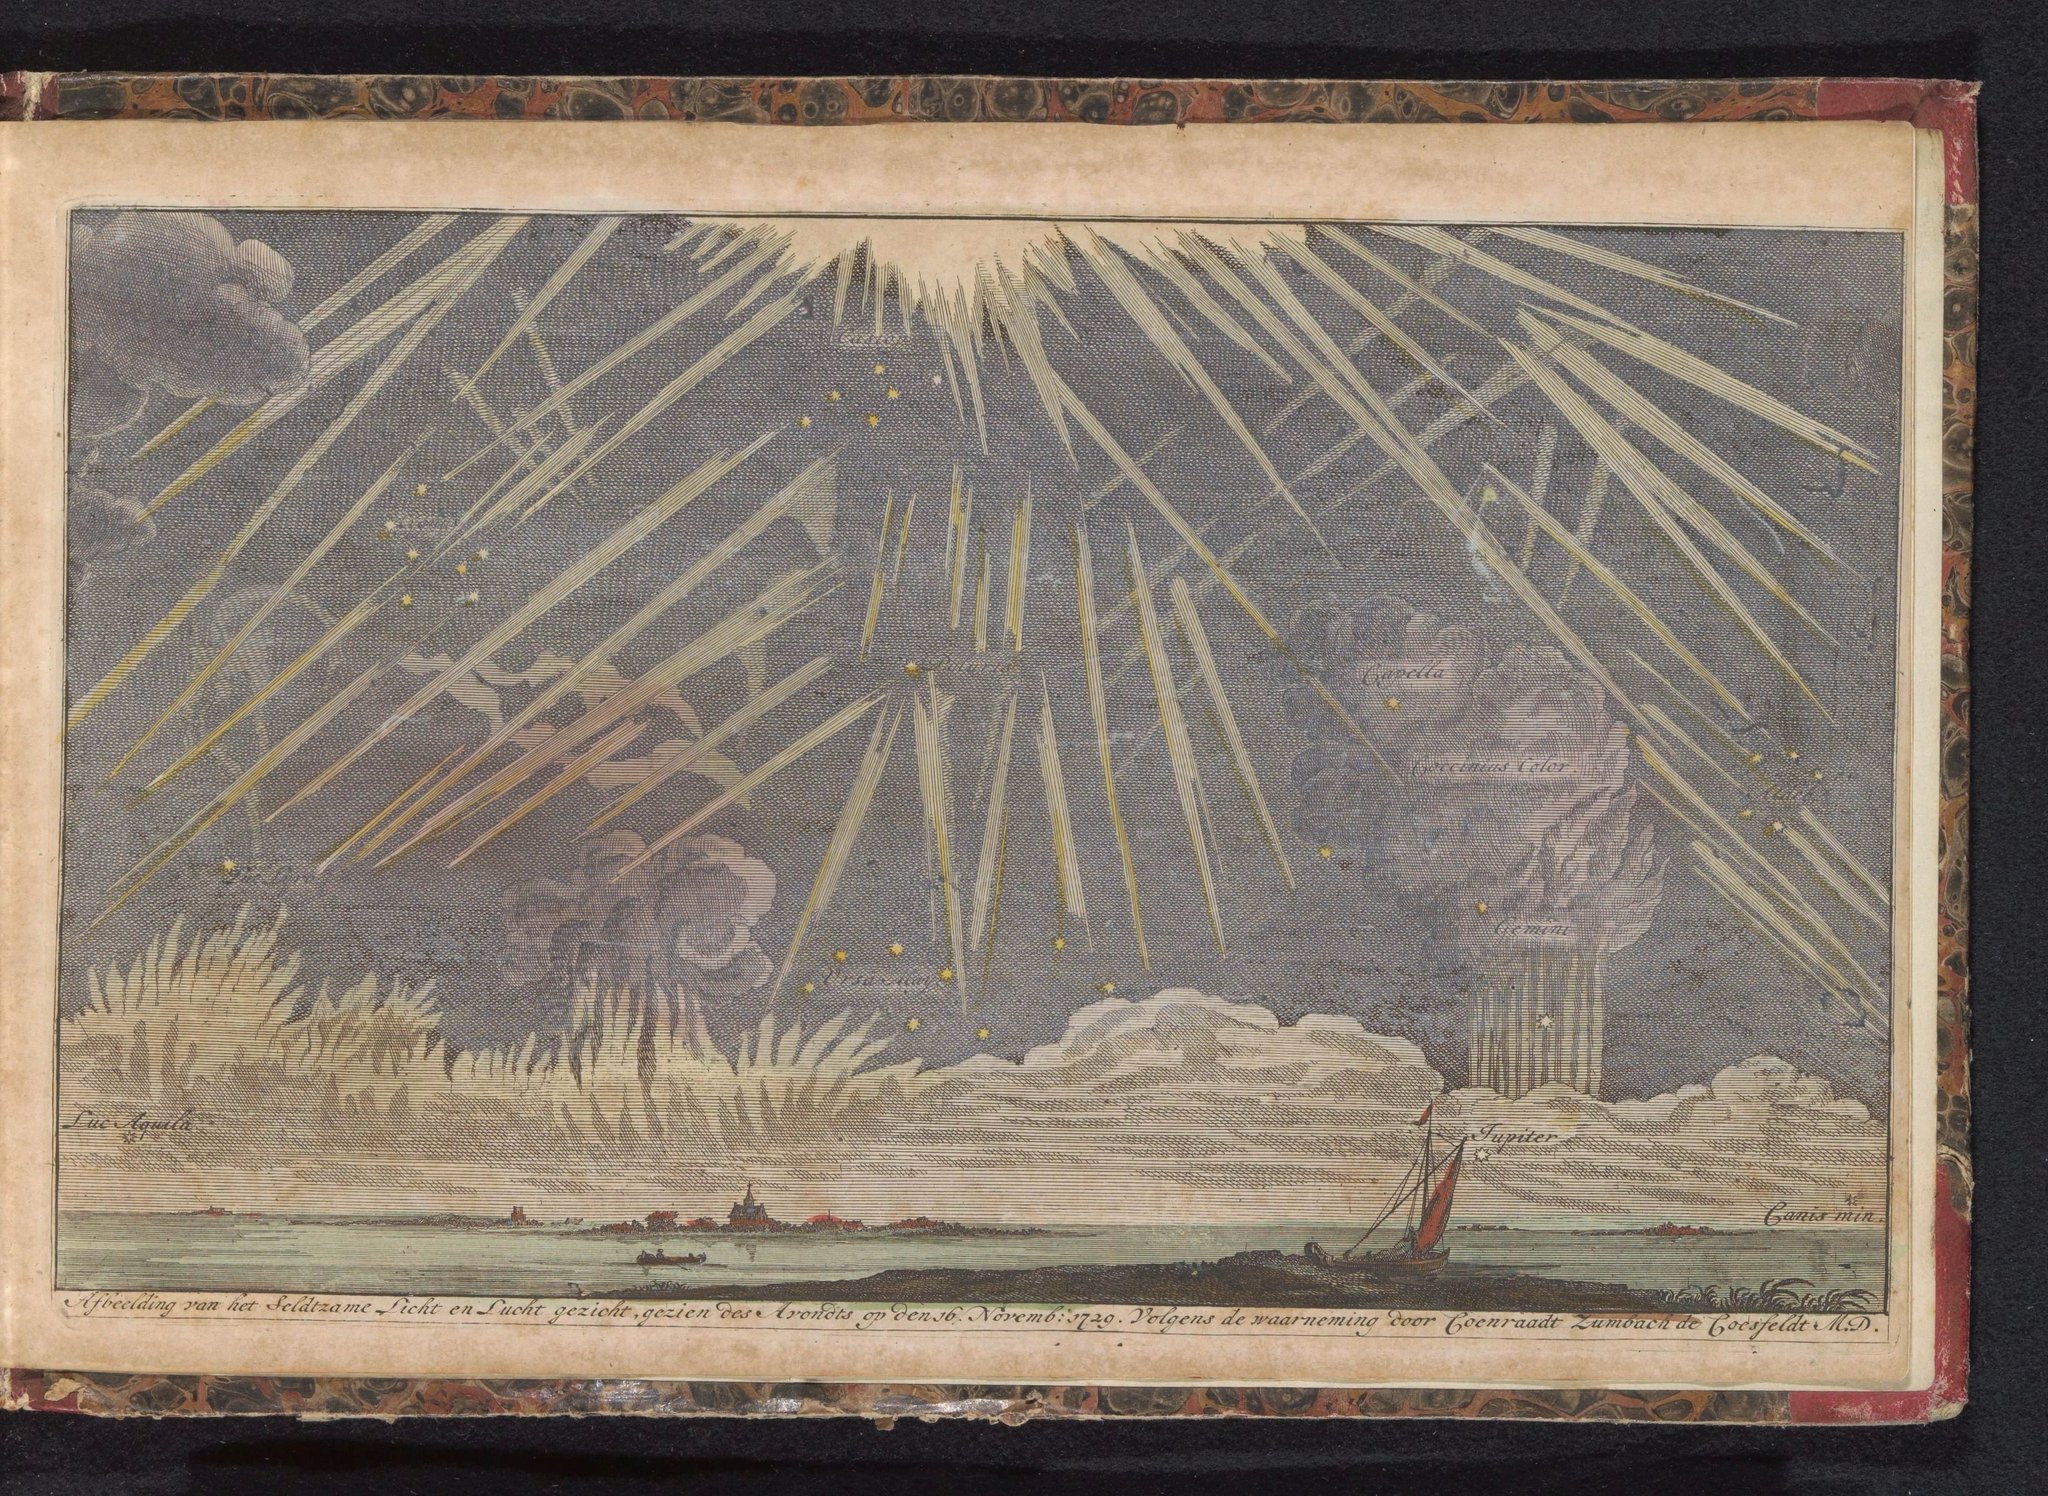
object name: print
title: Hemelverschijnselen, 1729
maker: Anonymous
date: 1729-1735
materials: paper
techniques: etching, hand coloring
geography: northern netherlands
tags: northern lights, 'aurora borealis', astronomical phenomena, leiden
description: Hemelverschijnselen waargenomen 16 november 1729 door Conrado Zumbach de Croesvelt, mogelijk boven Haarlem of Leiden. Bijzondere stralen, wolken, planeten en sterren in de hemel boven een meer en een dorp. Waarschijnlijk betreft het noorderlicht. Onderdeel van een atlas met 223 kaarten van landen en steden en oorlogstaferelen in Europa in de periode ca. 1690-1735.